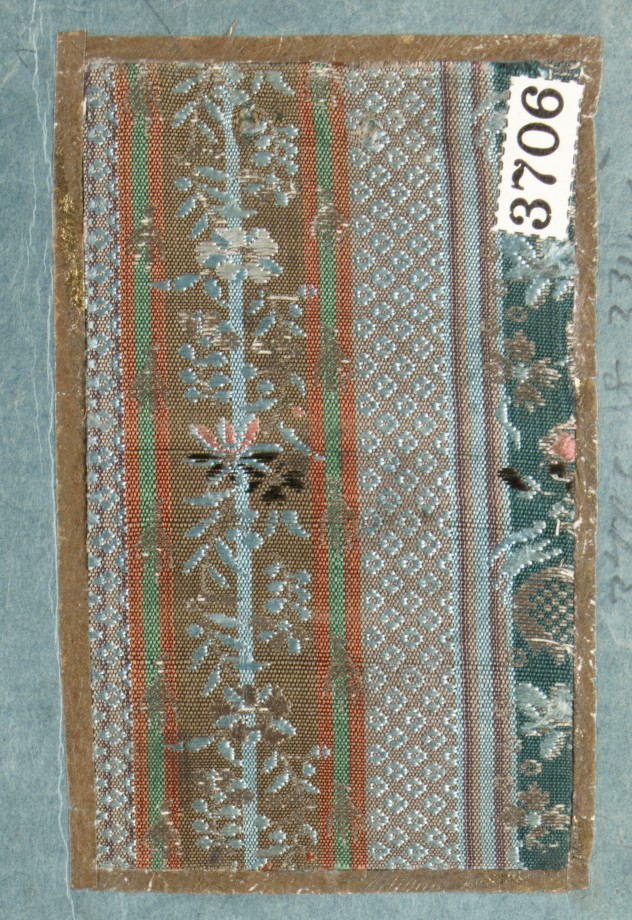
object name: sample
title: Textile Sample from Sample Book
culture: japanese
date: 1801-1900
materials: silk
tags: flowers